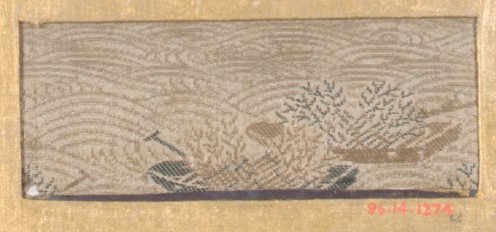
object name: piece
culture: japanese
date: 1701-1900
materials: silk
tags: boats